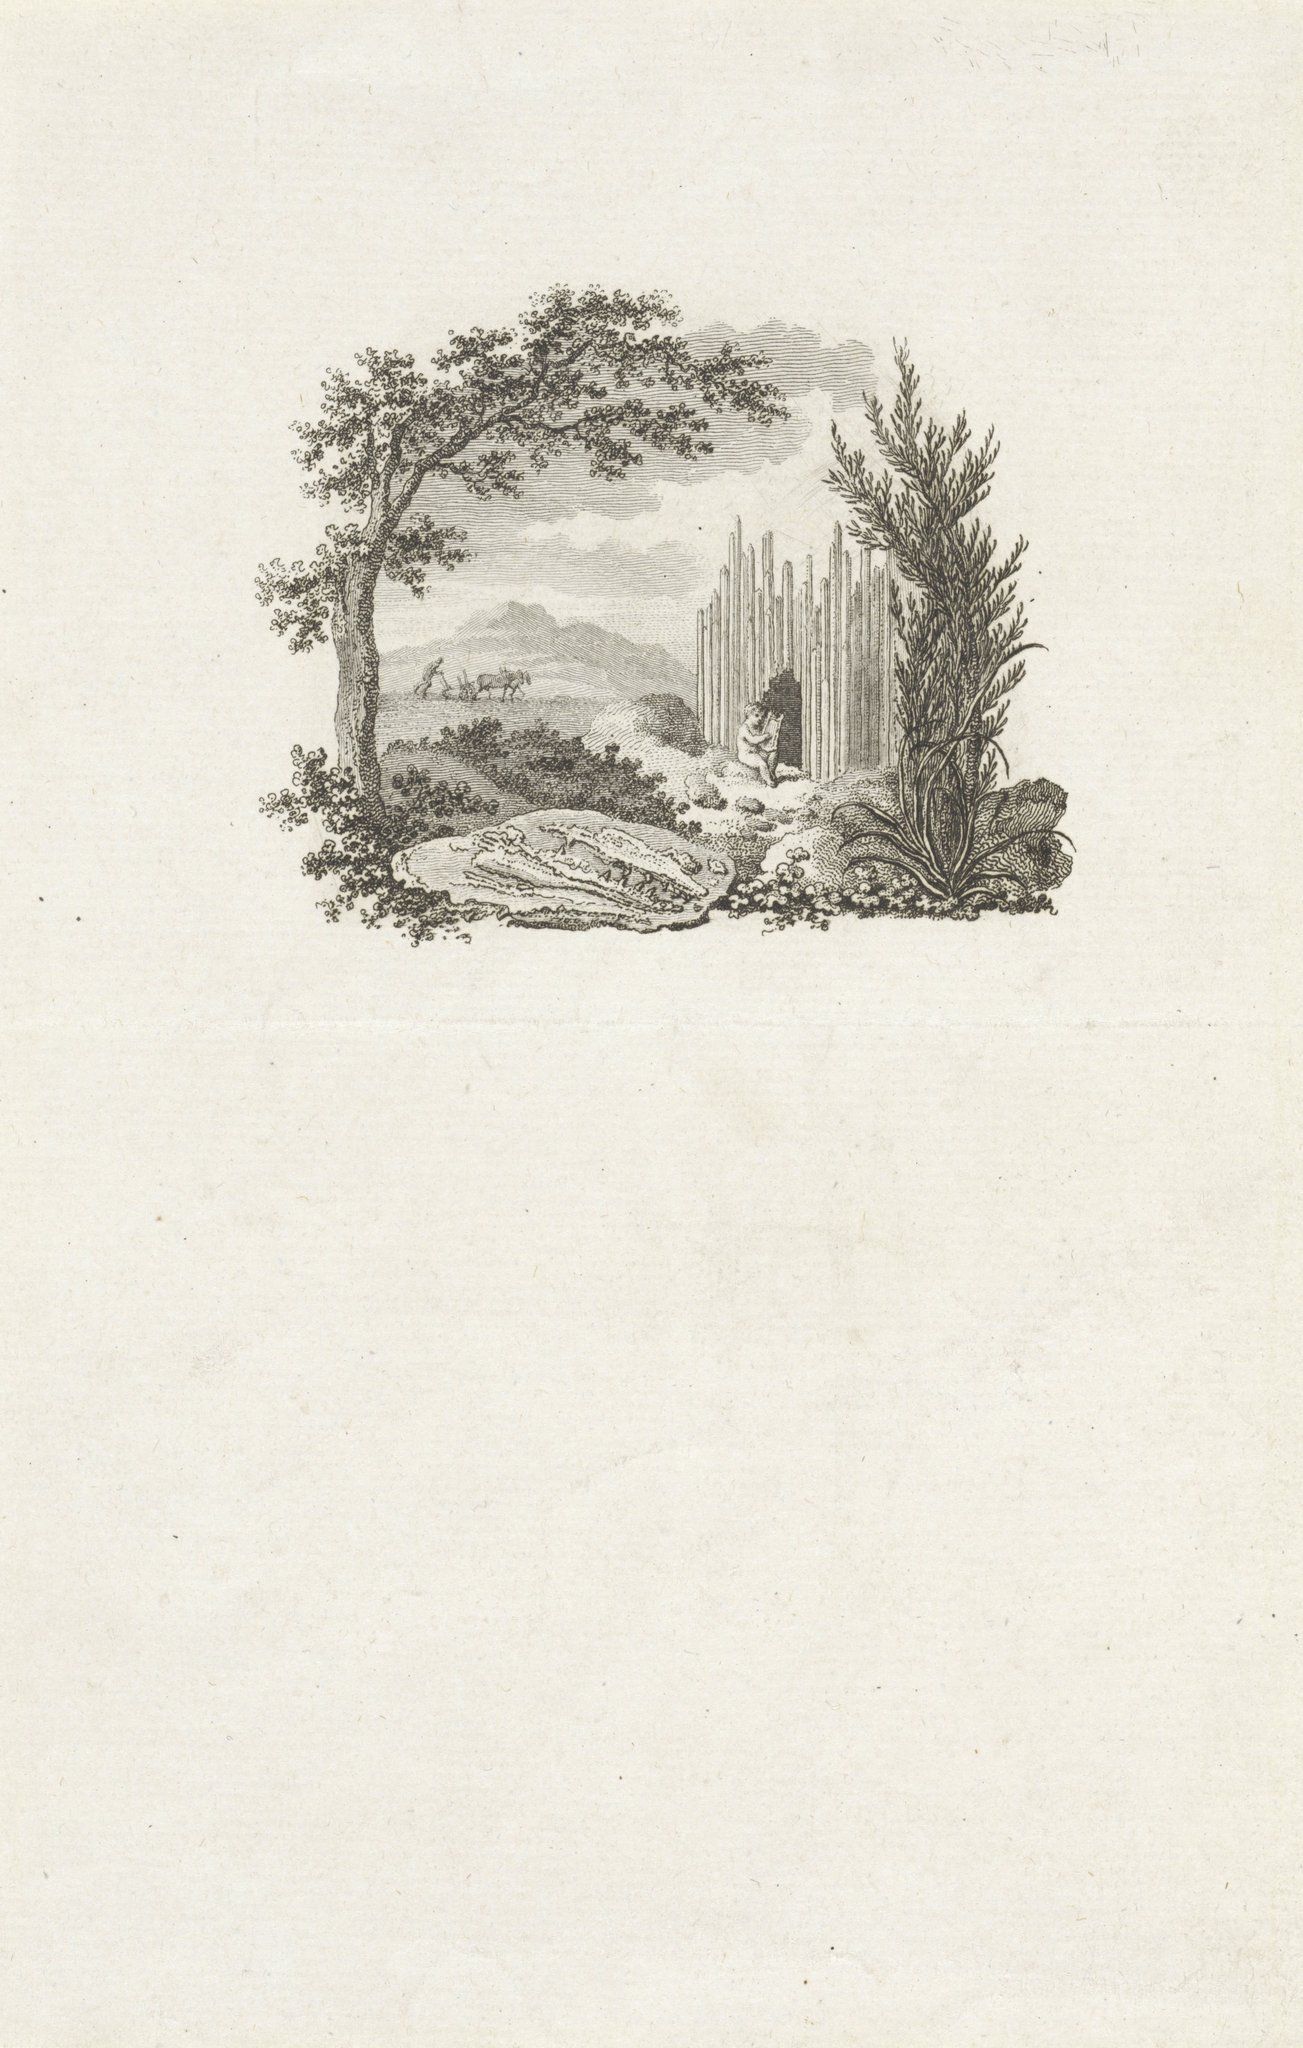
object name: print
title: Landschap met fossiel, ploegende boer en harpspelende putto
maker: reinier vinkeles (i)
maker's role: draughtsman, print maker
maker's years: 1741-1816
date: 1751-1816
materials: paper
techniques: etching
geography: amsterdam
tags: fossil plants, landscapes, agricultural implements: plough, cupids: 'amores', 'amoretti', 'putti'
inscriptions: collector's mark: Lugt 2228